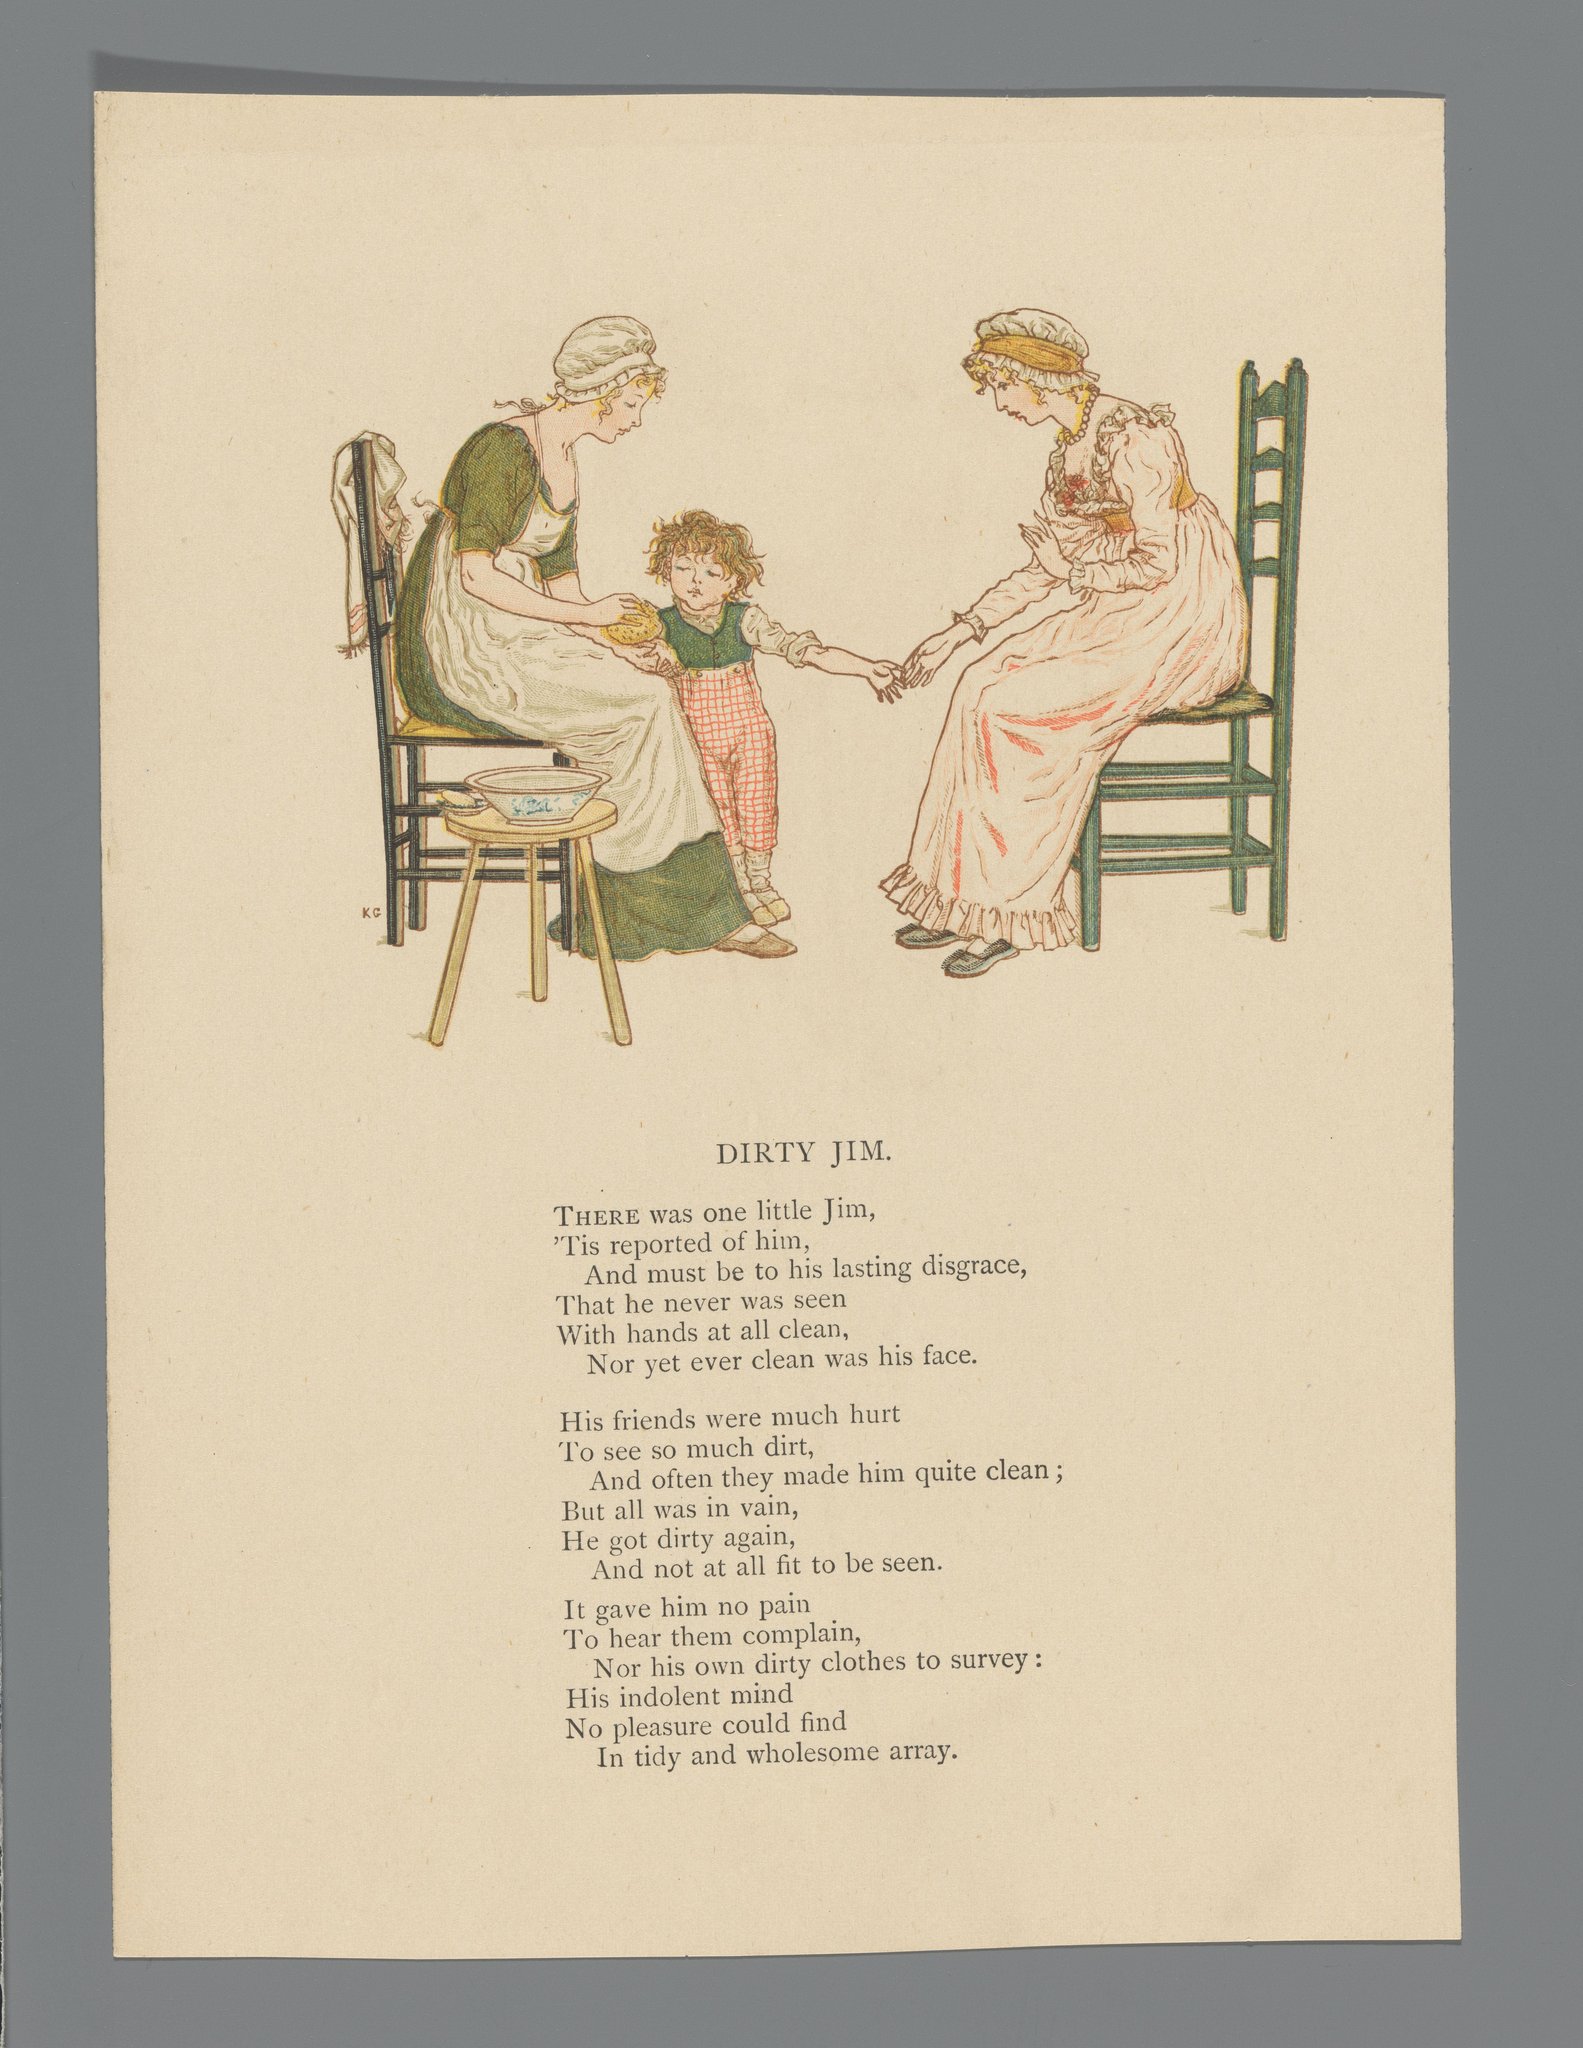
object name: book illustration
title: Kind en twee vrouwen op een stoel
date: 1883-1927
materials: paper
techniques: wood engraving, letterpress printing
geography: london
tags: child, adult woman (+ two persons), chair, washing one's hands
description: Prent uit: Jane en Ann Taylor. Little Ann and other poems. Londen: George Routledge & Sons, [1883], p. 24. Of een latere uitgave.